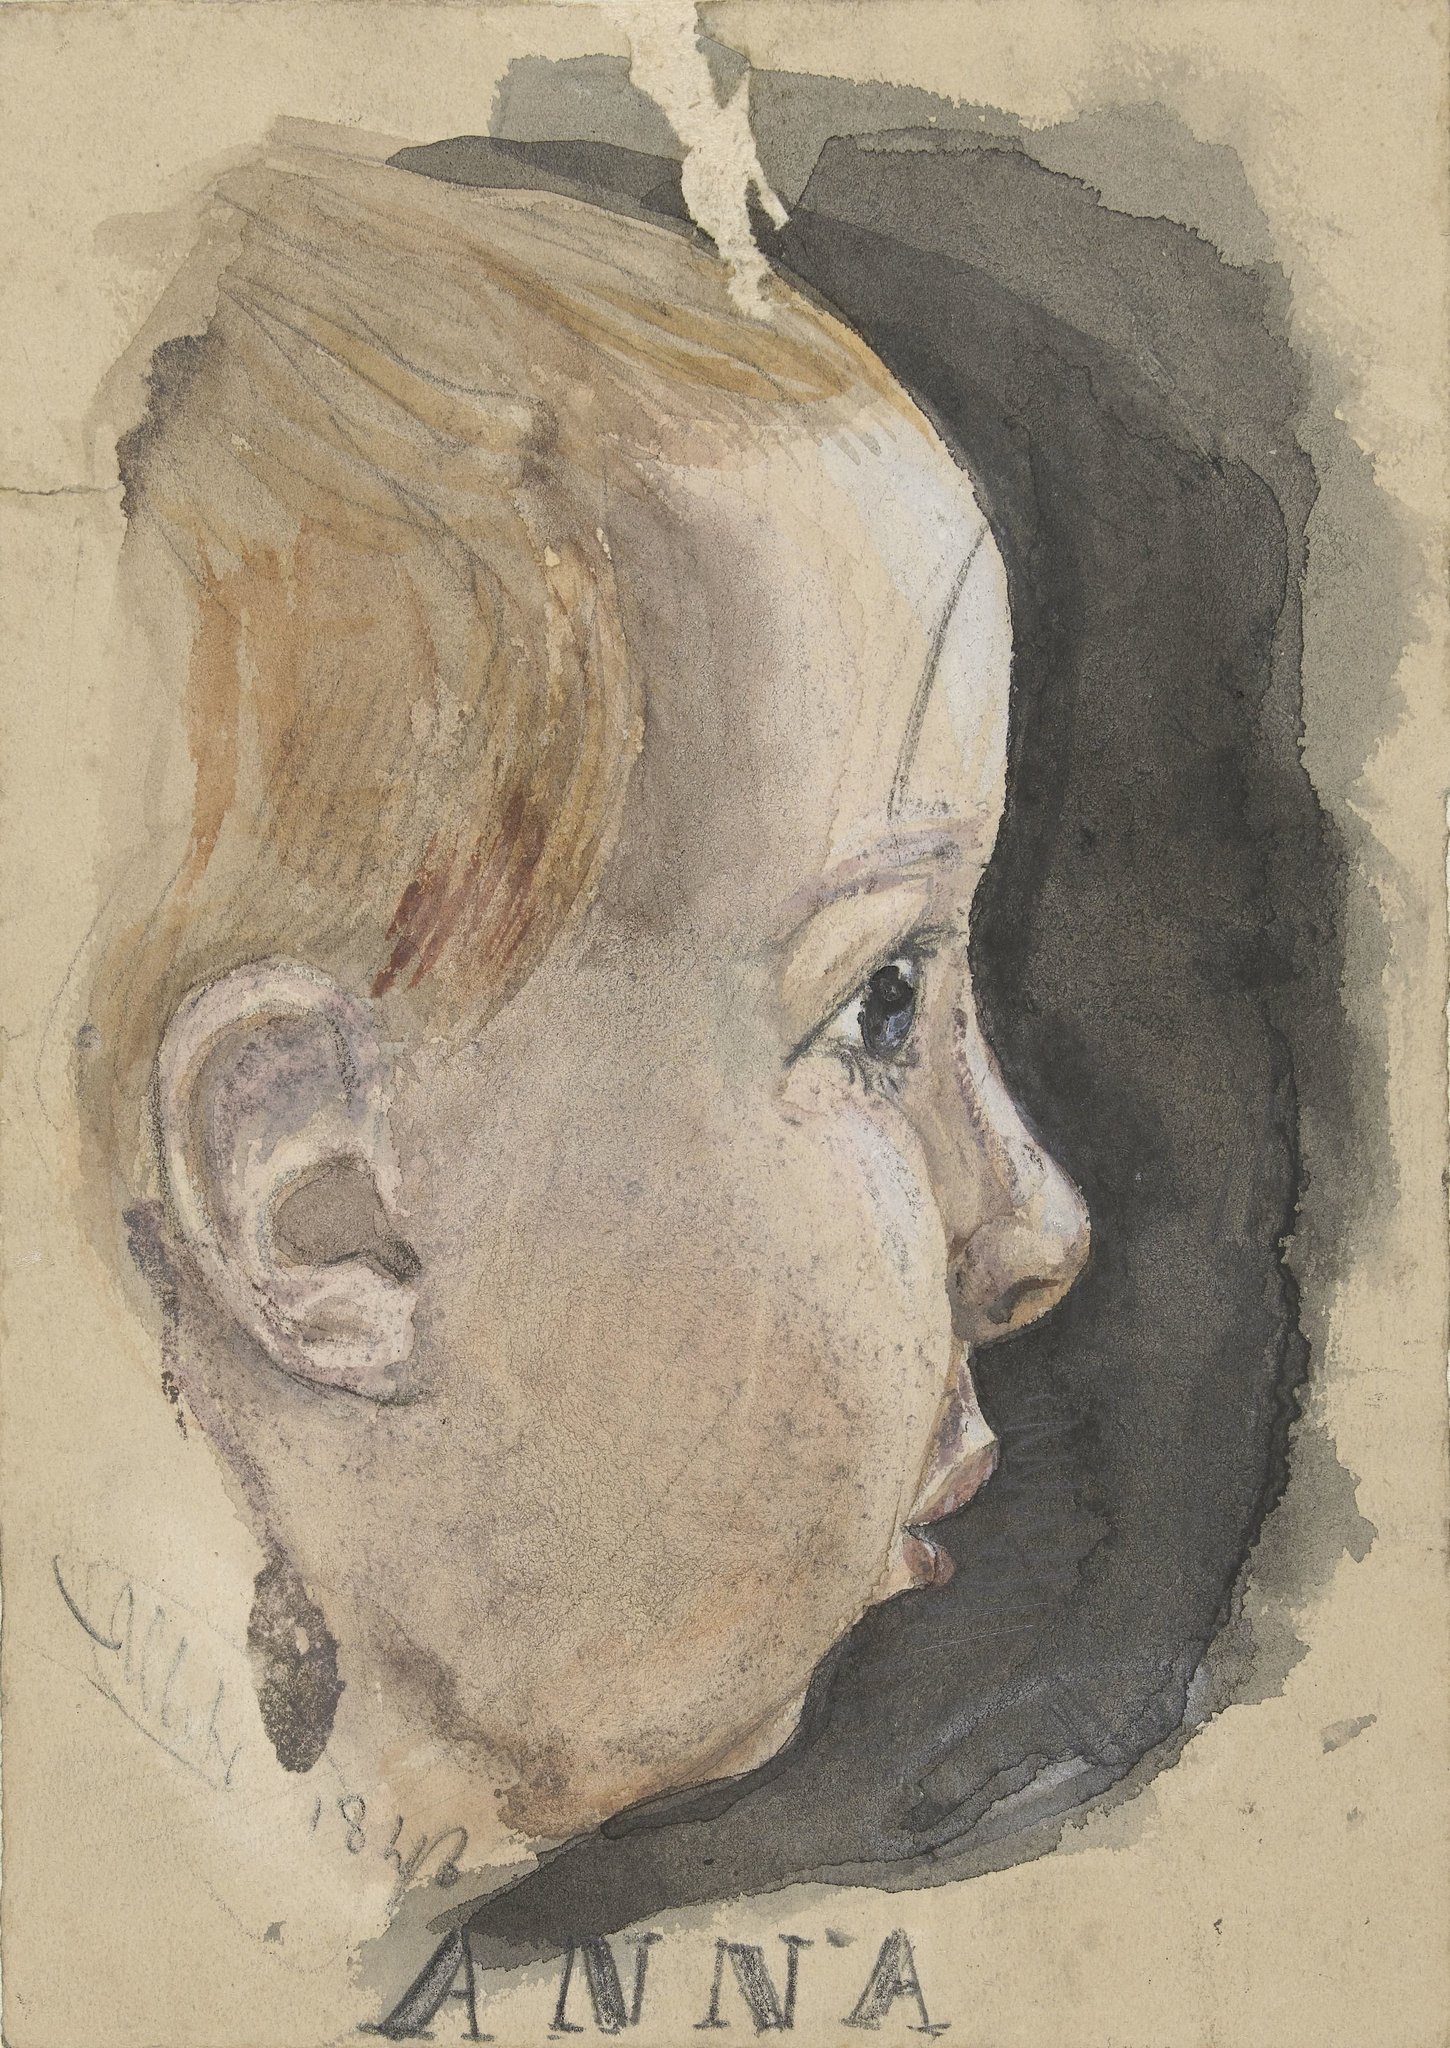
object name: drawing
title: Portret van Anna Allebé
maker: august allebé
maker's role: draughtsman, print maker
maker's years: 1838-1927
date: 1846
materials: chalk, paper, pencil, watercolor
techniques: brush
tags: anna allebé, historical persons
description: Portret van Anna Allebé, de zuster van August Allebé.